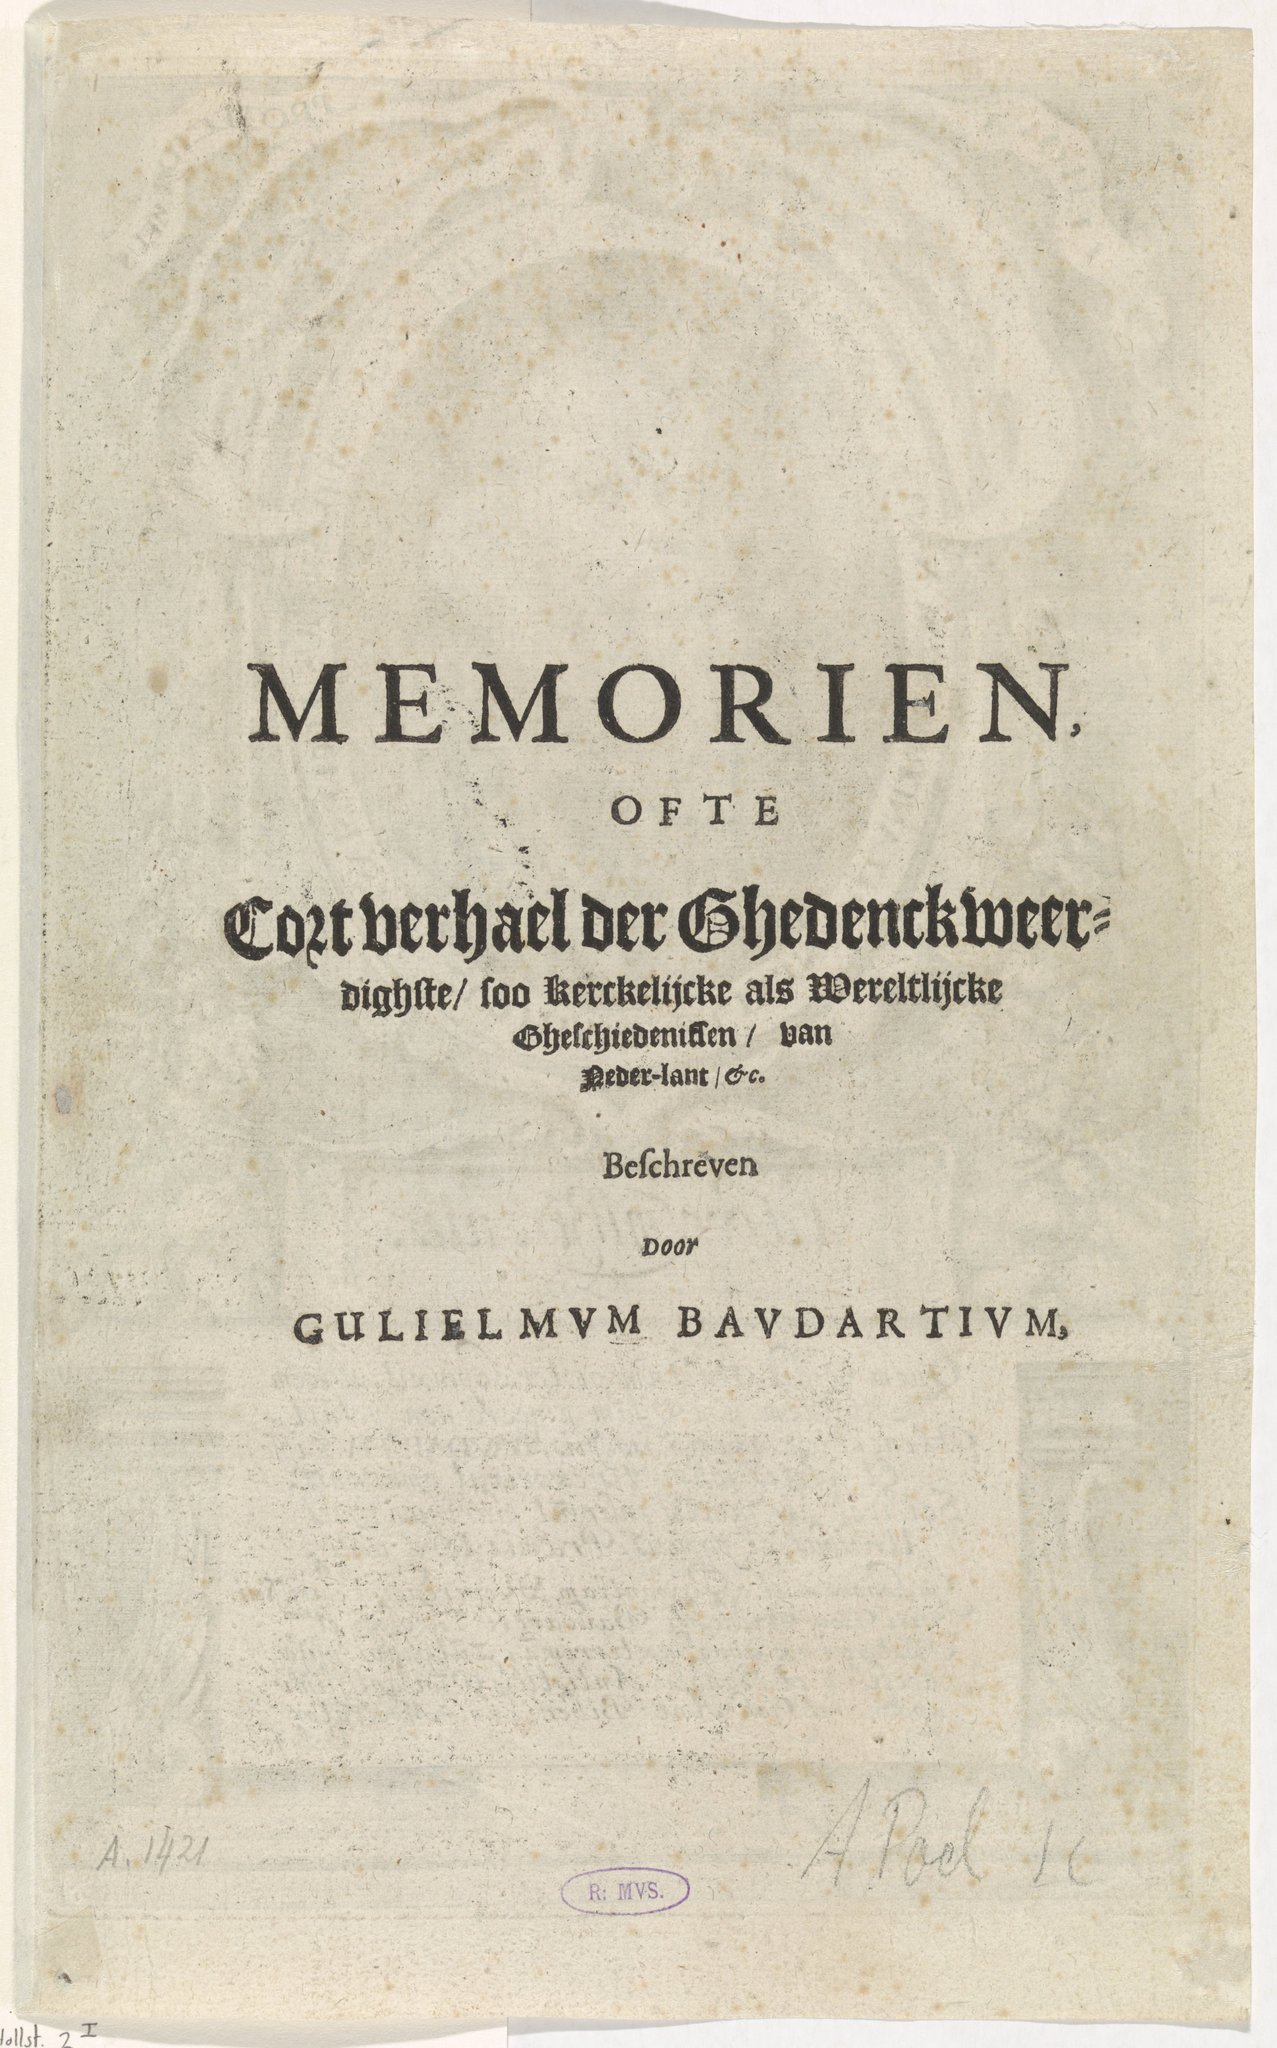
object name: print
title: Titelpagina voor: Willem Baudartius, Memoryen ofte Cort verhael der gedenck-weerdichste (...) gheschiedenissen, 1624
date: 1624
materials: paper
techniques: letterpress printing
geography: arnhem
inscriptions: collector's mark: Lugt 2228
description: Titelpagina voor: Willem Baudartius. Memoryen ofte Cort verhael der gedenck-weerdichste so kercklicke als werltlicke gheschiedenissen (...) van den iaere 1603. tot in het iaer 1624. Twee delen. Tweede vermeerderde editie. Arnhem: Jan Jansz, 1624 en Zutphen: Andries Jansz van Aelst, 1624. Op versozijde auteursportret.